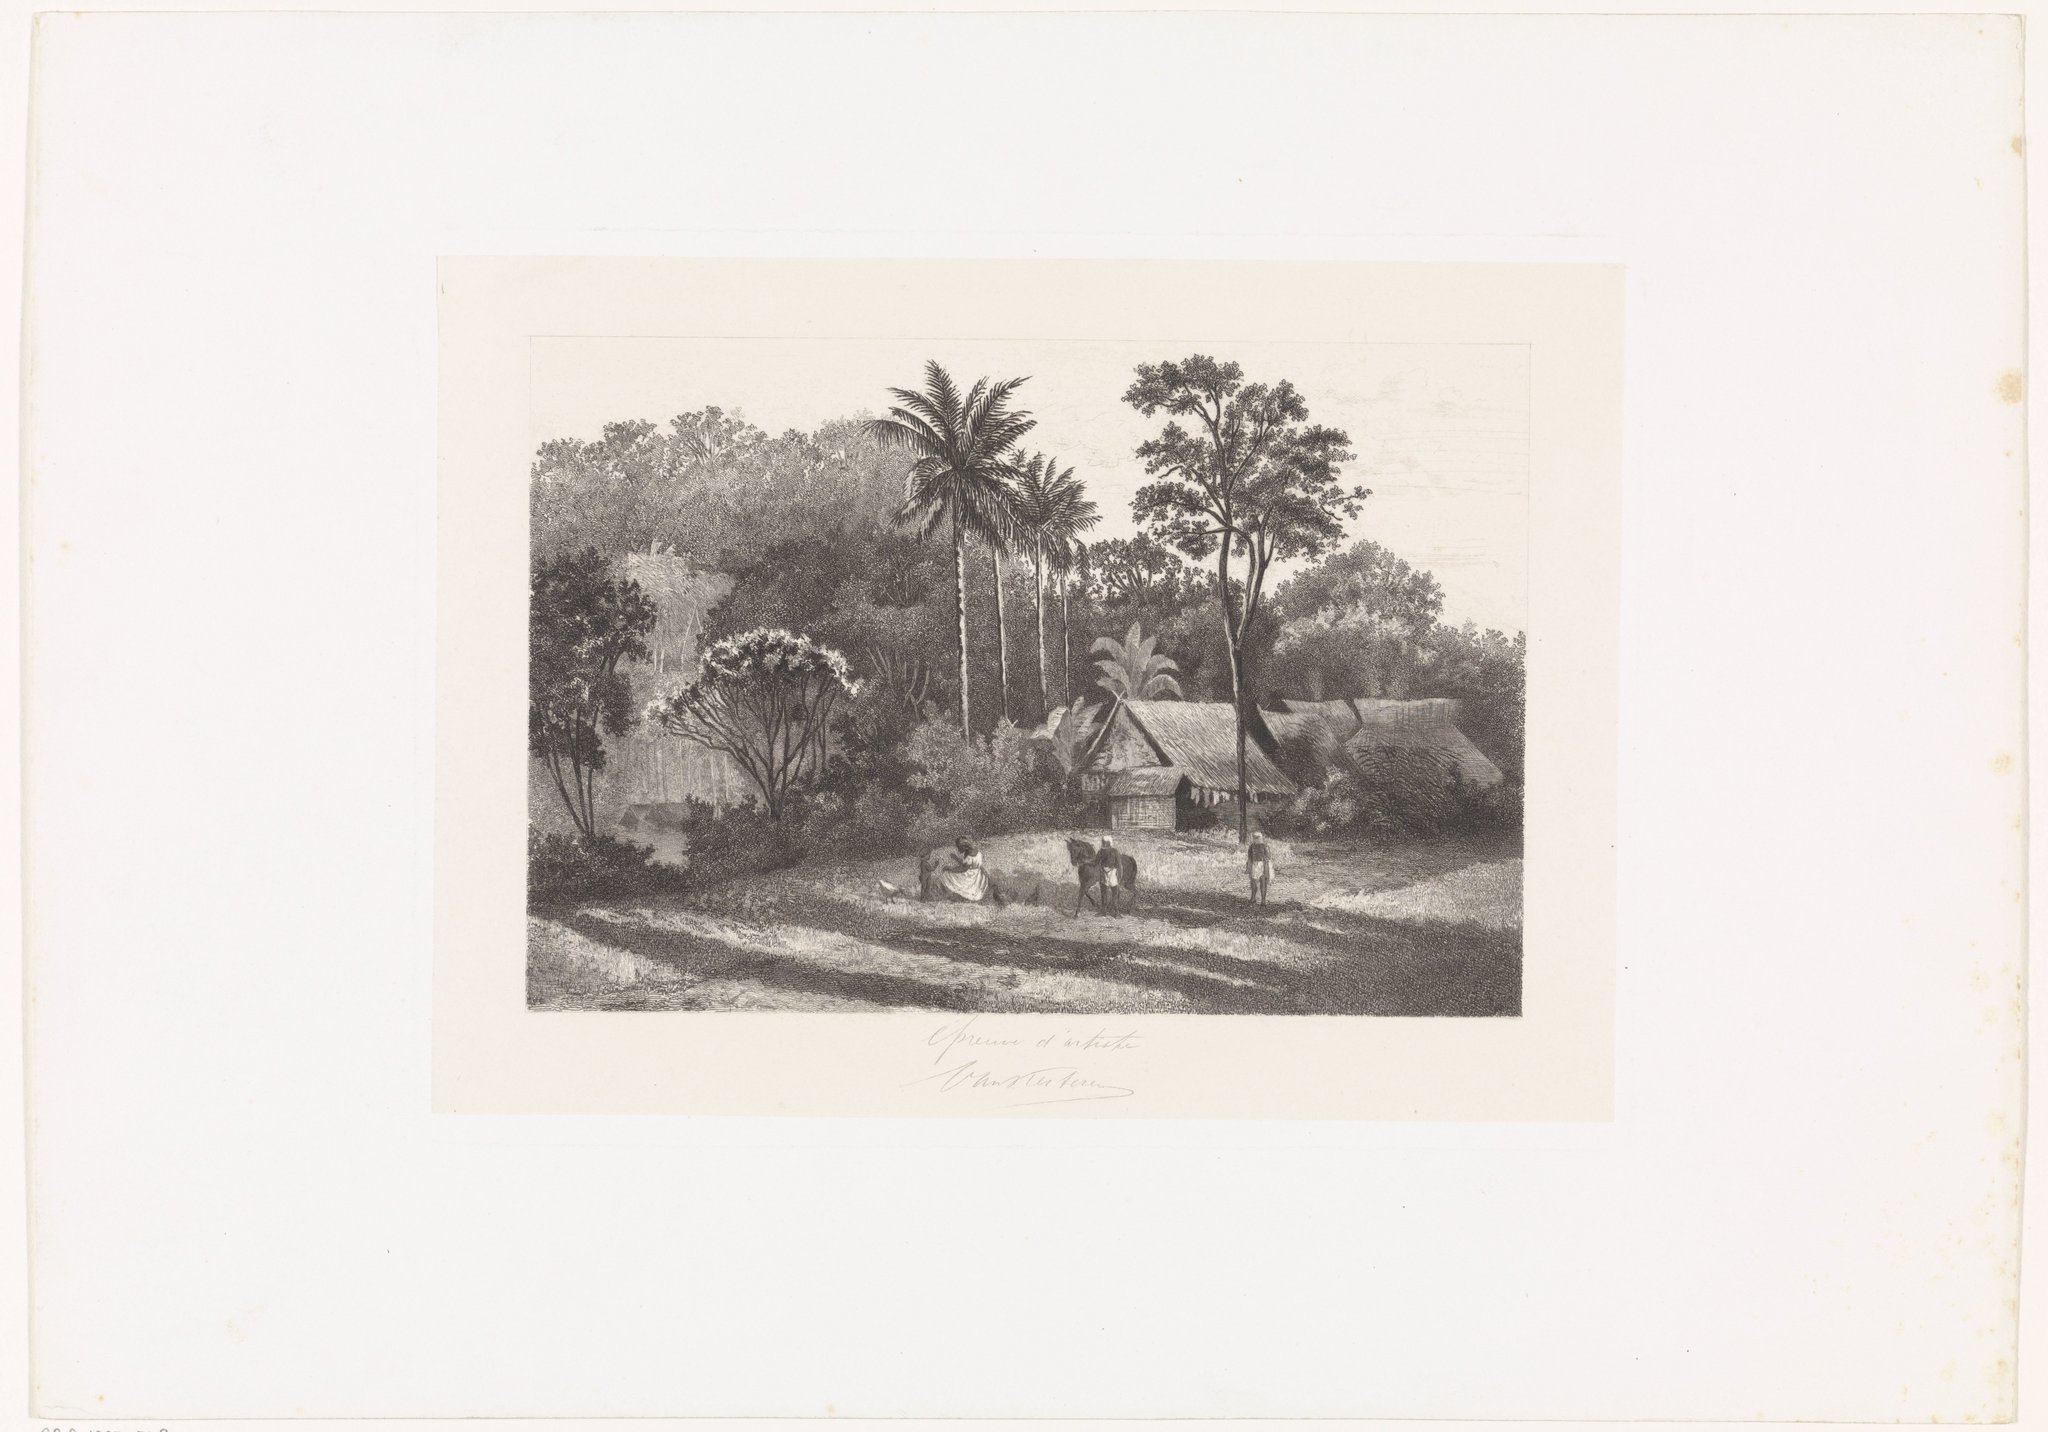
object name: print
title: Tropisch landschap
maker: christiaan lodewijk van kesteren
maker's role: print maker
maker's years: 1832-1897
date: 1842-1897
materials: paper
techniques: etching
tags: landscapes in tropical and sub-tropical regions, fowl (cock, hen, chicken, etc.), horse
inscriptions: collector's mark: Lugt 2228, collector's mark: Lugt 2760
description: In een tropisch landschap met palmen en ander geboomte zit een moeder met haar kind bij de kippen. Naast hen staat een man met een paard en daarachter een andere man. Op de achtergrond is een aantal huizen te zien.